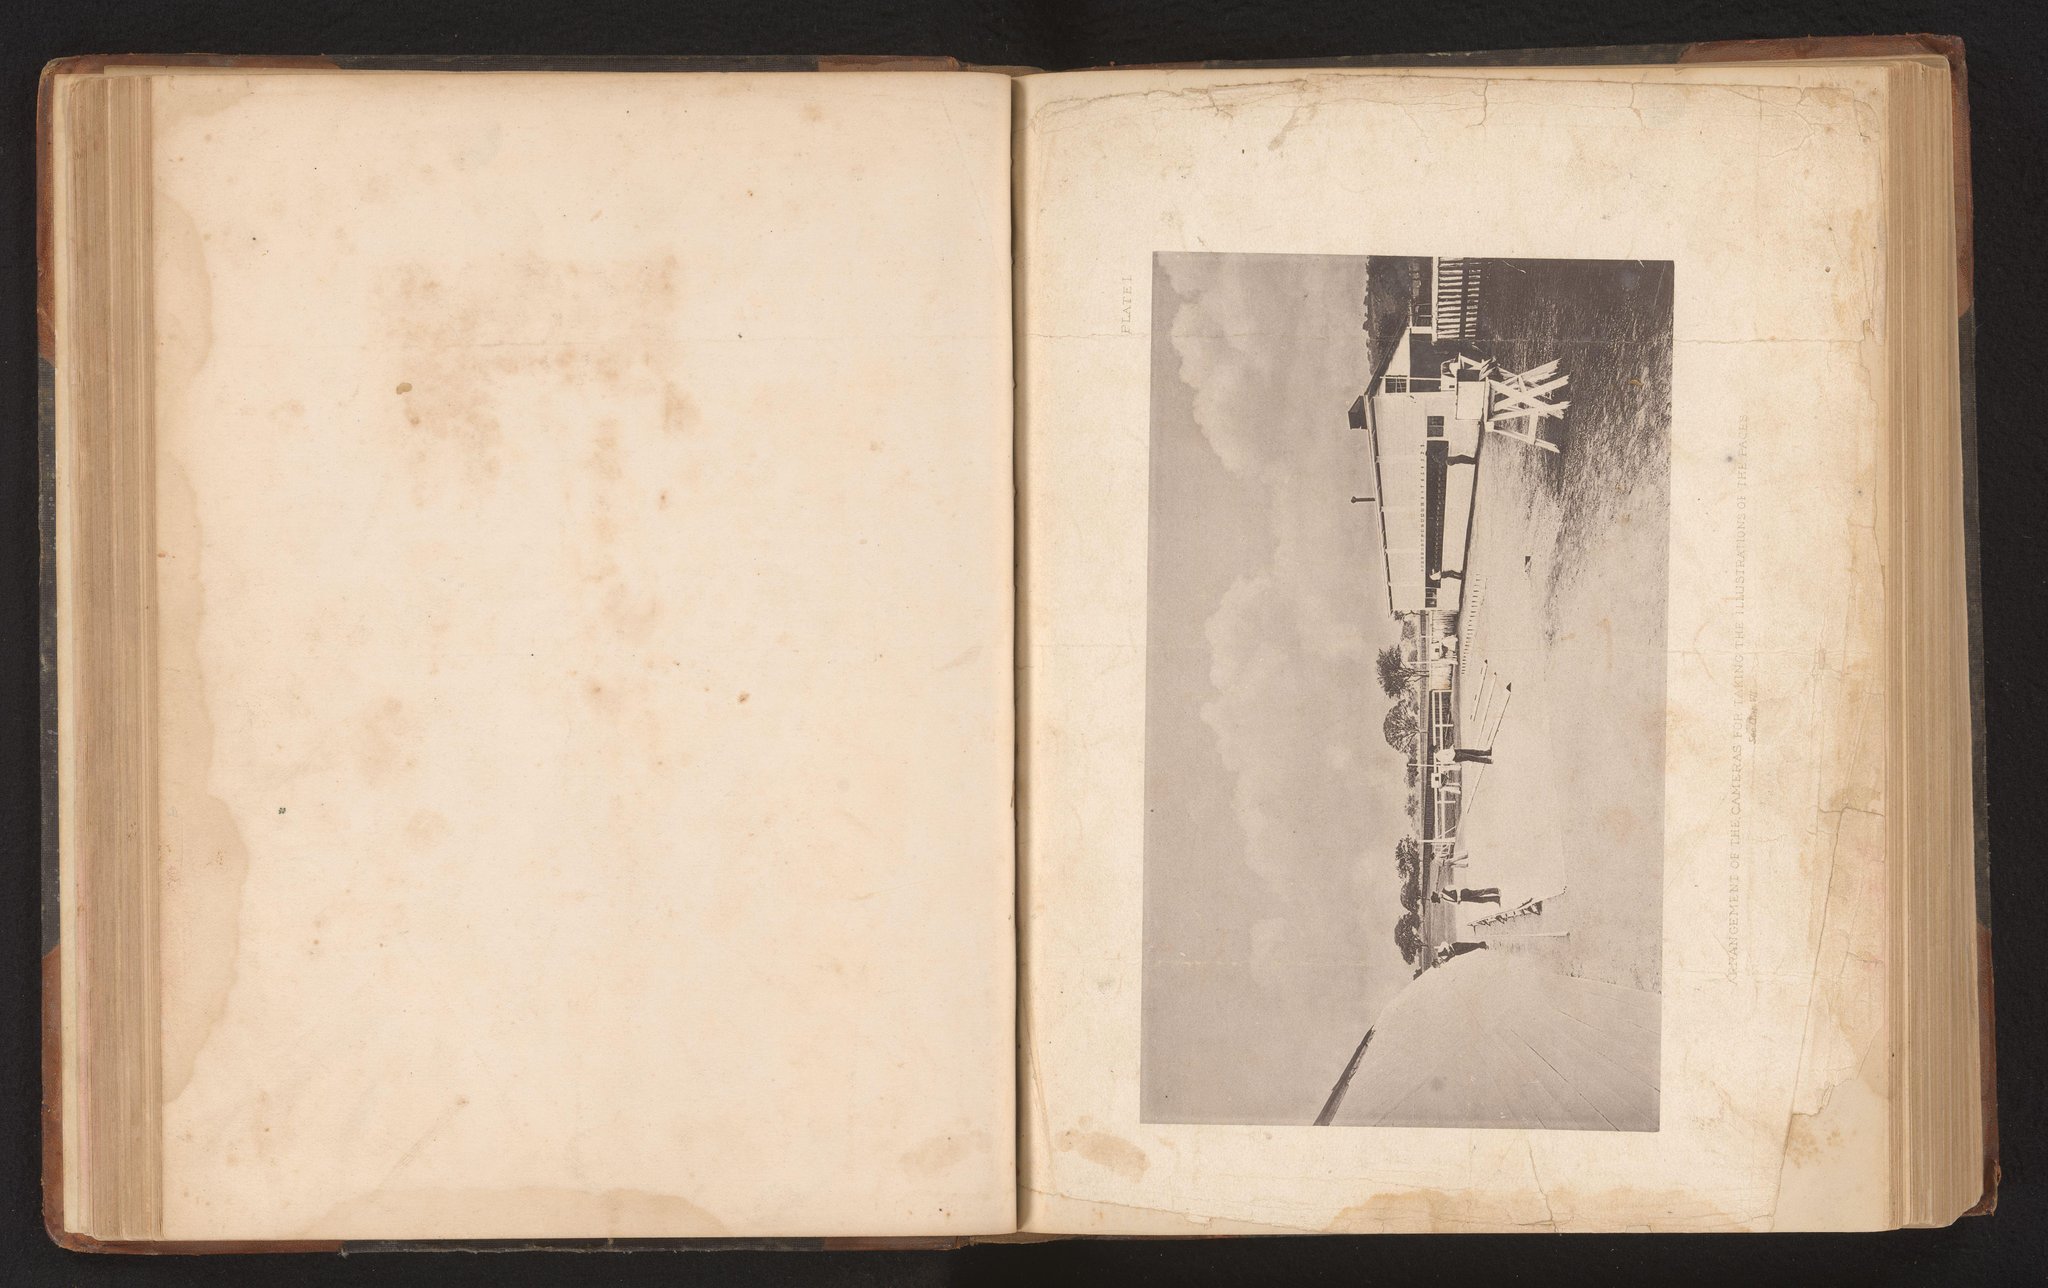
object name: page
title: Opstelling van Eadward Muybridge voor het fotograferen van rennende paarden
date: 1877-1882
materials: paper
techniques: heliotype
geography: palo alto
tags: racing on animal mount, research, experiment (~ production), experiment, test ~ science and technology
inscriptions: inscription: ‘Plate I./ See Chap. VII.’